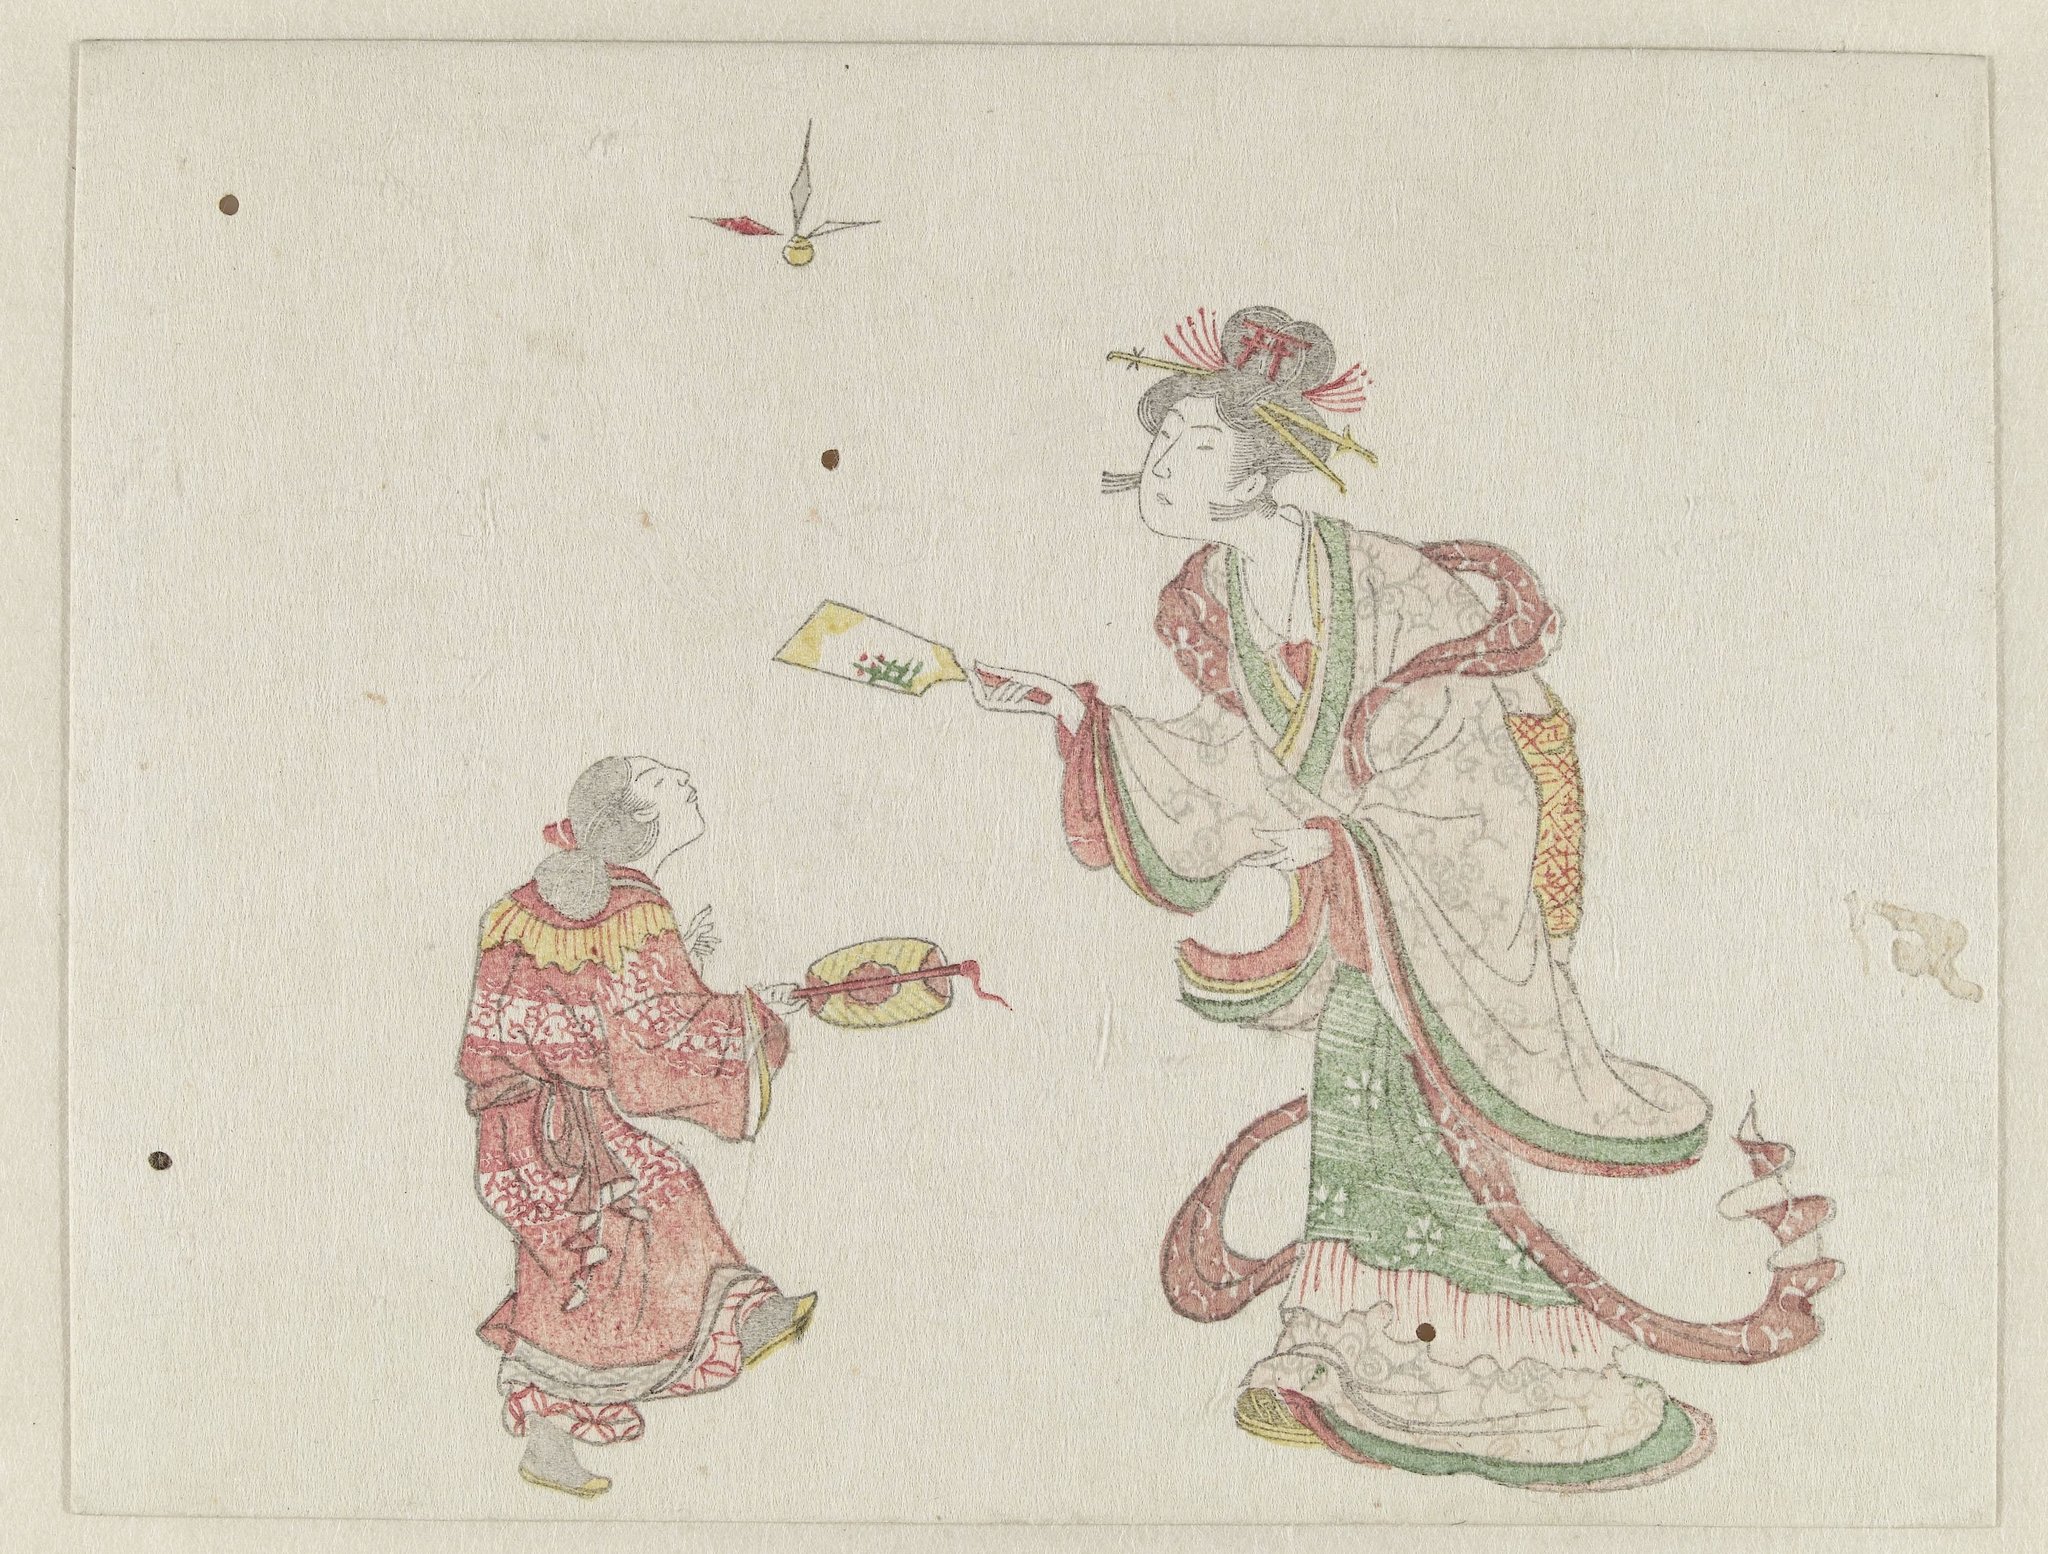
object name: egoyomi kalenderblad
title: Egoyomi voor het jaar van de slang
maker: Anonymous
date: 1797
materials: paper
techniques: woodcut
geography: japan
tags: mother and child(ren), woman and child(ren) (family group), ball games in which ball is hit with racket (or hand)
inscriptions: collector's mark: Lugt 2228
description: Vrouw en meisje spelen met pluimbal en slagplankjes. De nummers van de lange maanden zijn zichtbaar op de obi van de vrouw.